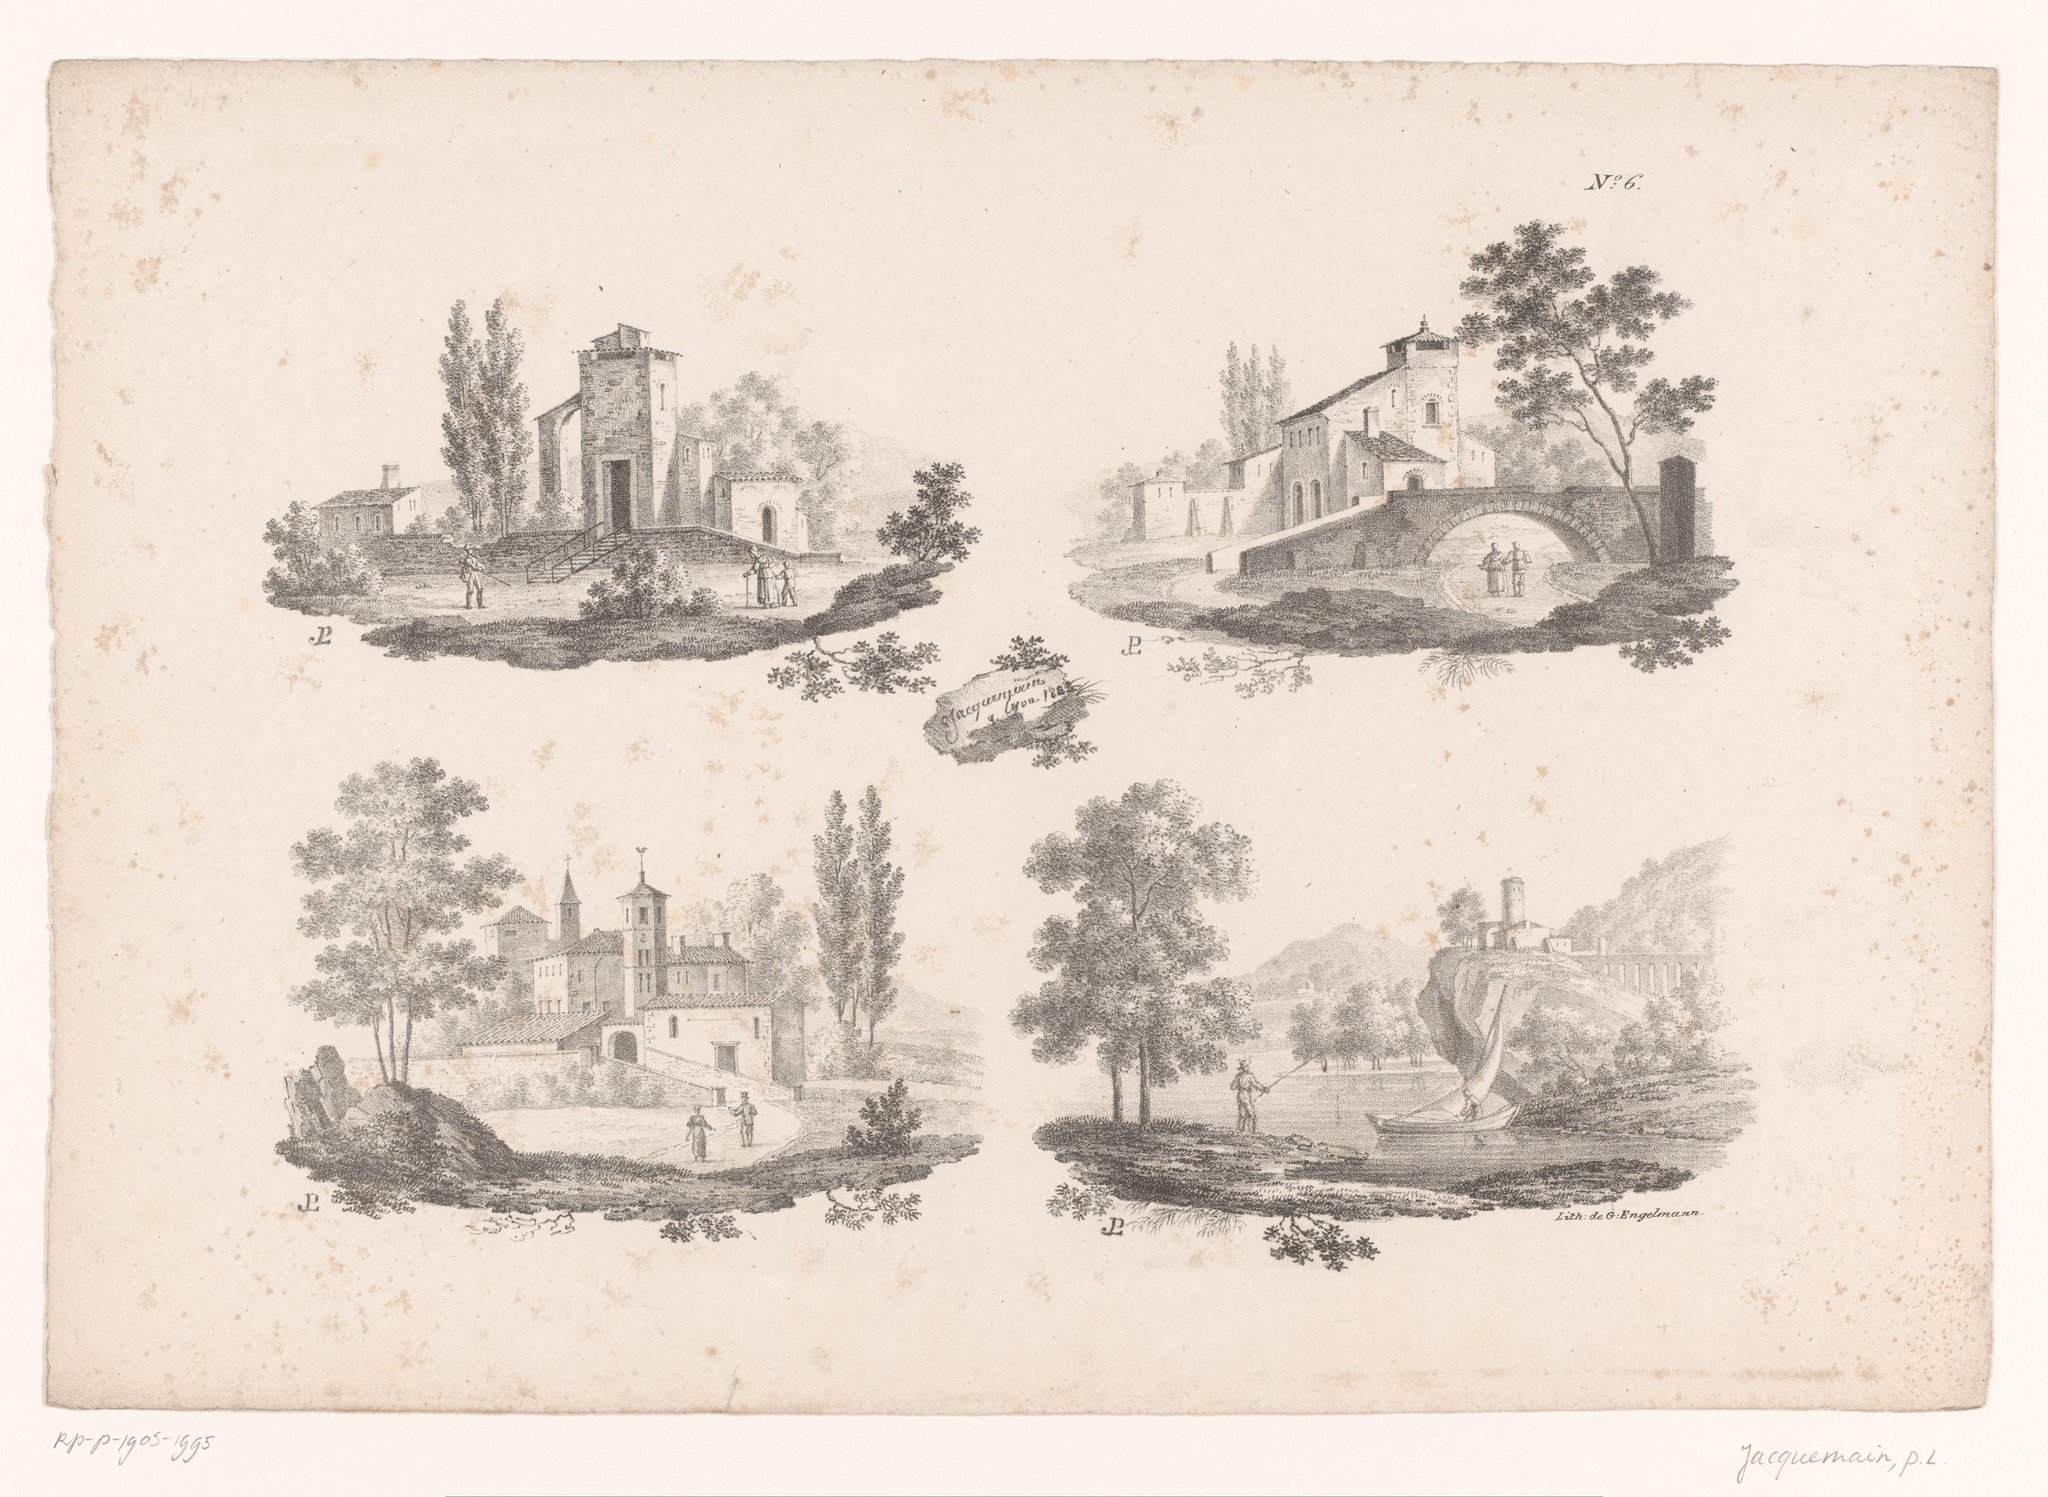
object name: print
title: Vier voorstellingen van stadspoorten, bruggen en torens in een landschap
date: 1823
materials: paper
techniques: lithograph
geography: lyon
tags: village-gate (+ city(-scape) with figures, staffage), landscape with bridge, viaduct or aqueduct (+ city(-scape) with figures, staffage), lake (+ landscape with figures, staffage)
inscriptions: collector's mark: Lugt 2228a